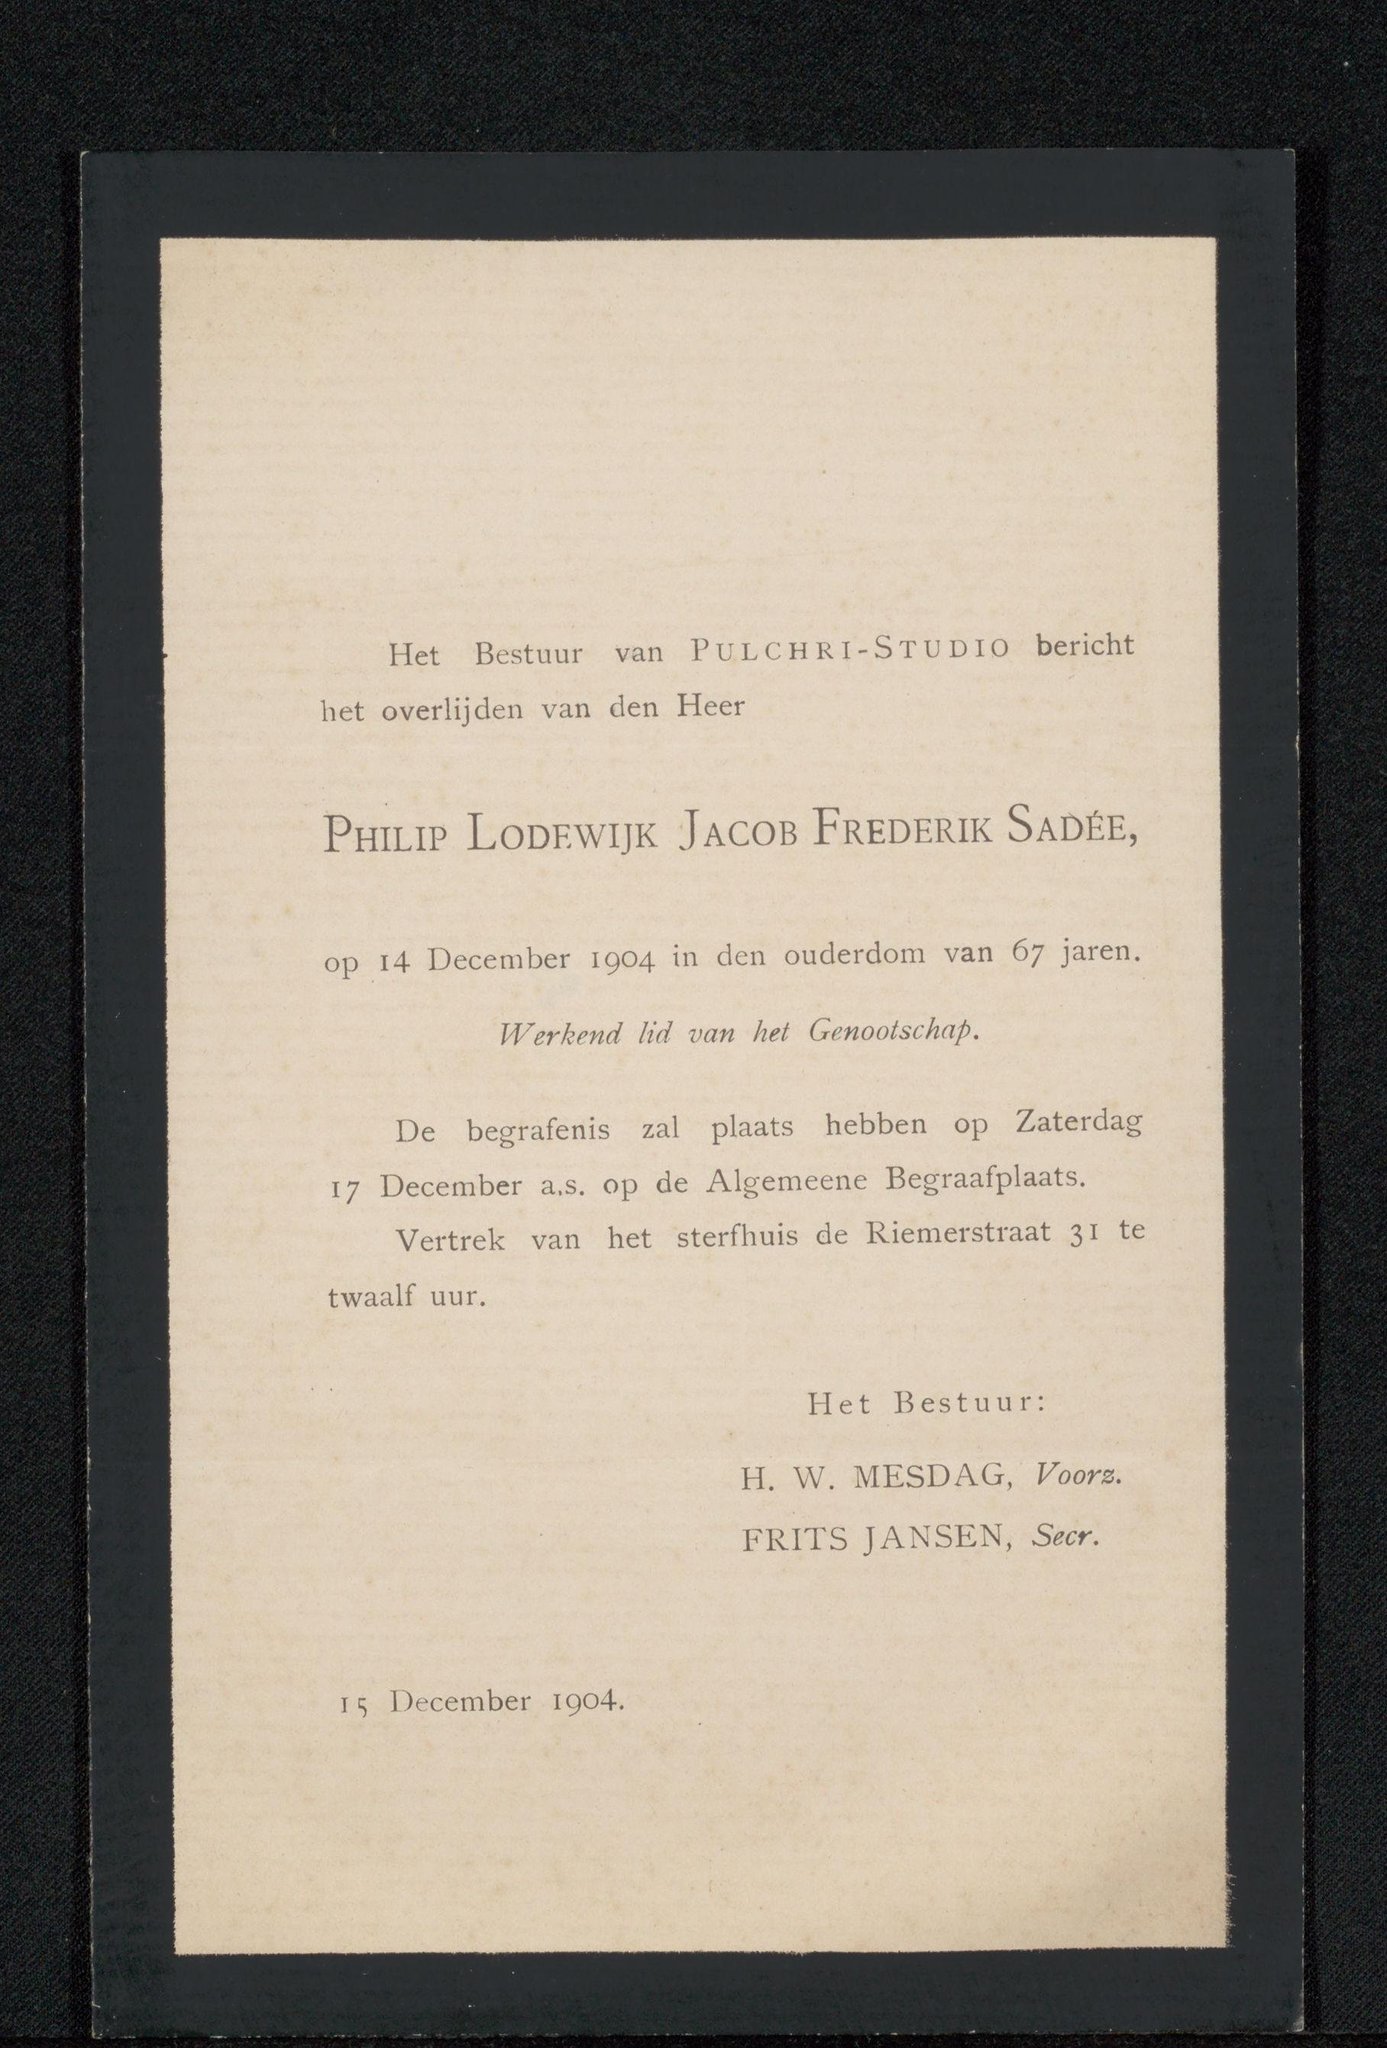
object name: overlijdensbericht, overlijdensadvertentie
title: Overlijdensbericht aan Philip Zilcken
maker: frits jansen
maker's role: painter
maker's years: 1856-1928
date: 1904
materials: paper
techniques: printing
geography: the hague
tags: print maker, philip sadée, painter, draughtsman, philip zilcken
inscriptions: collector's mark: ‘RPK’